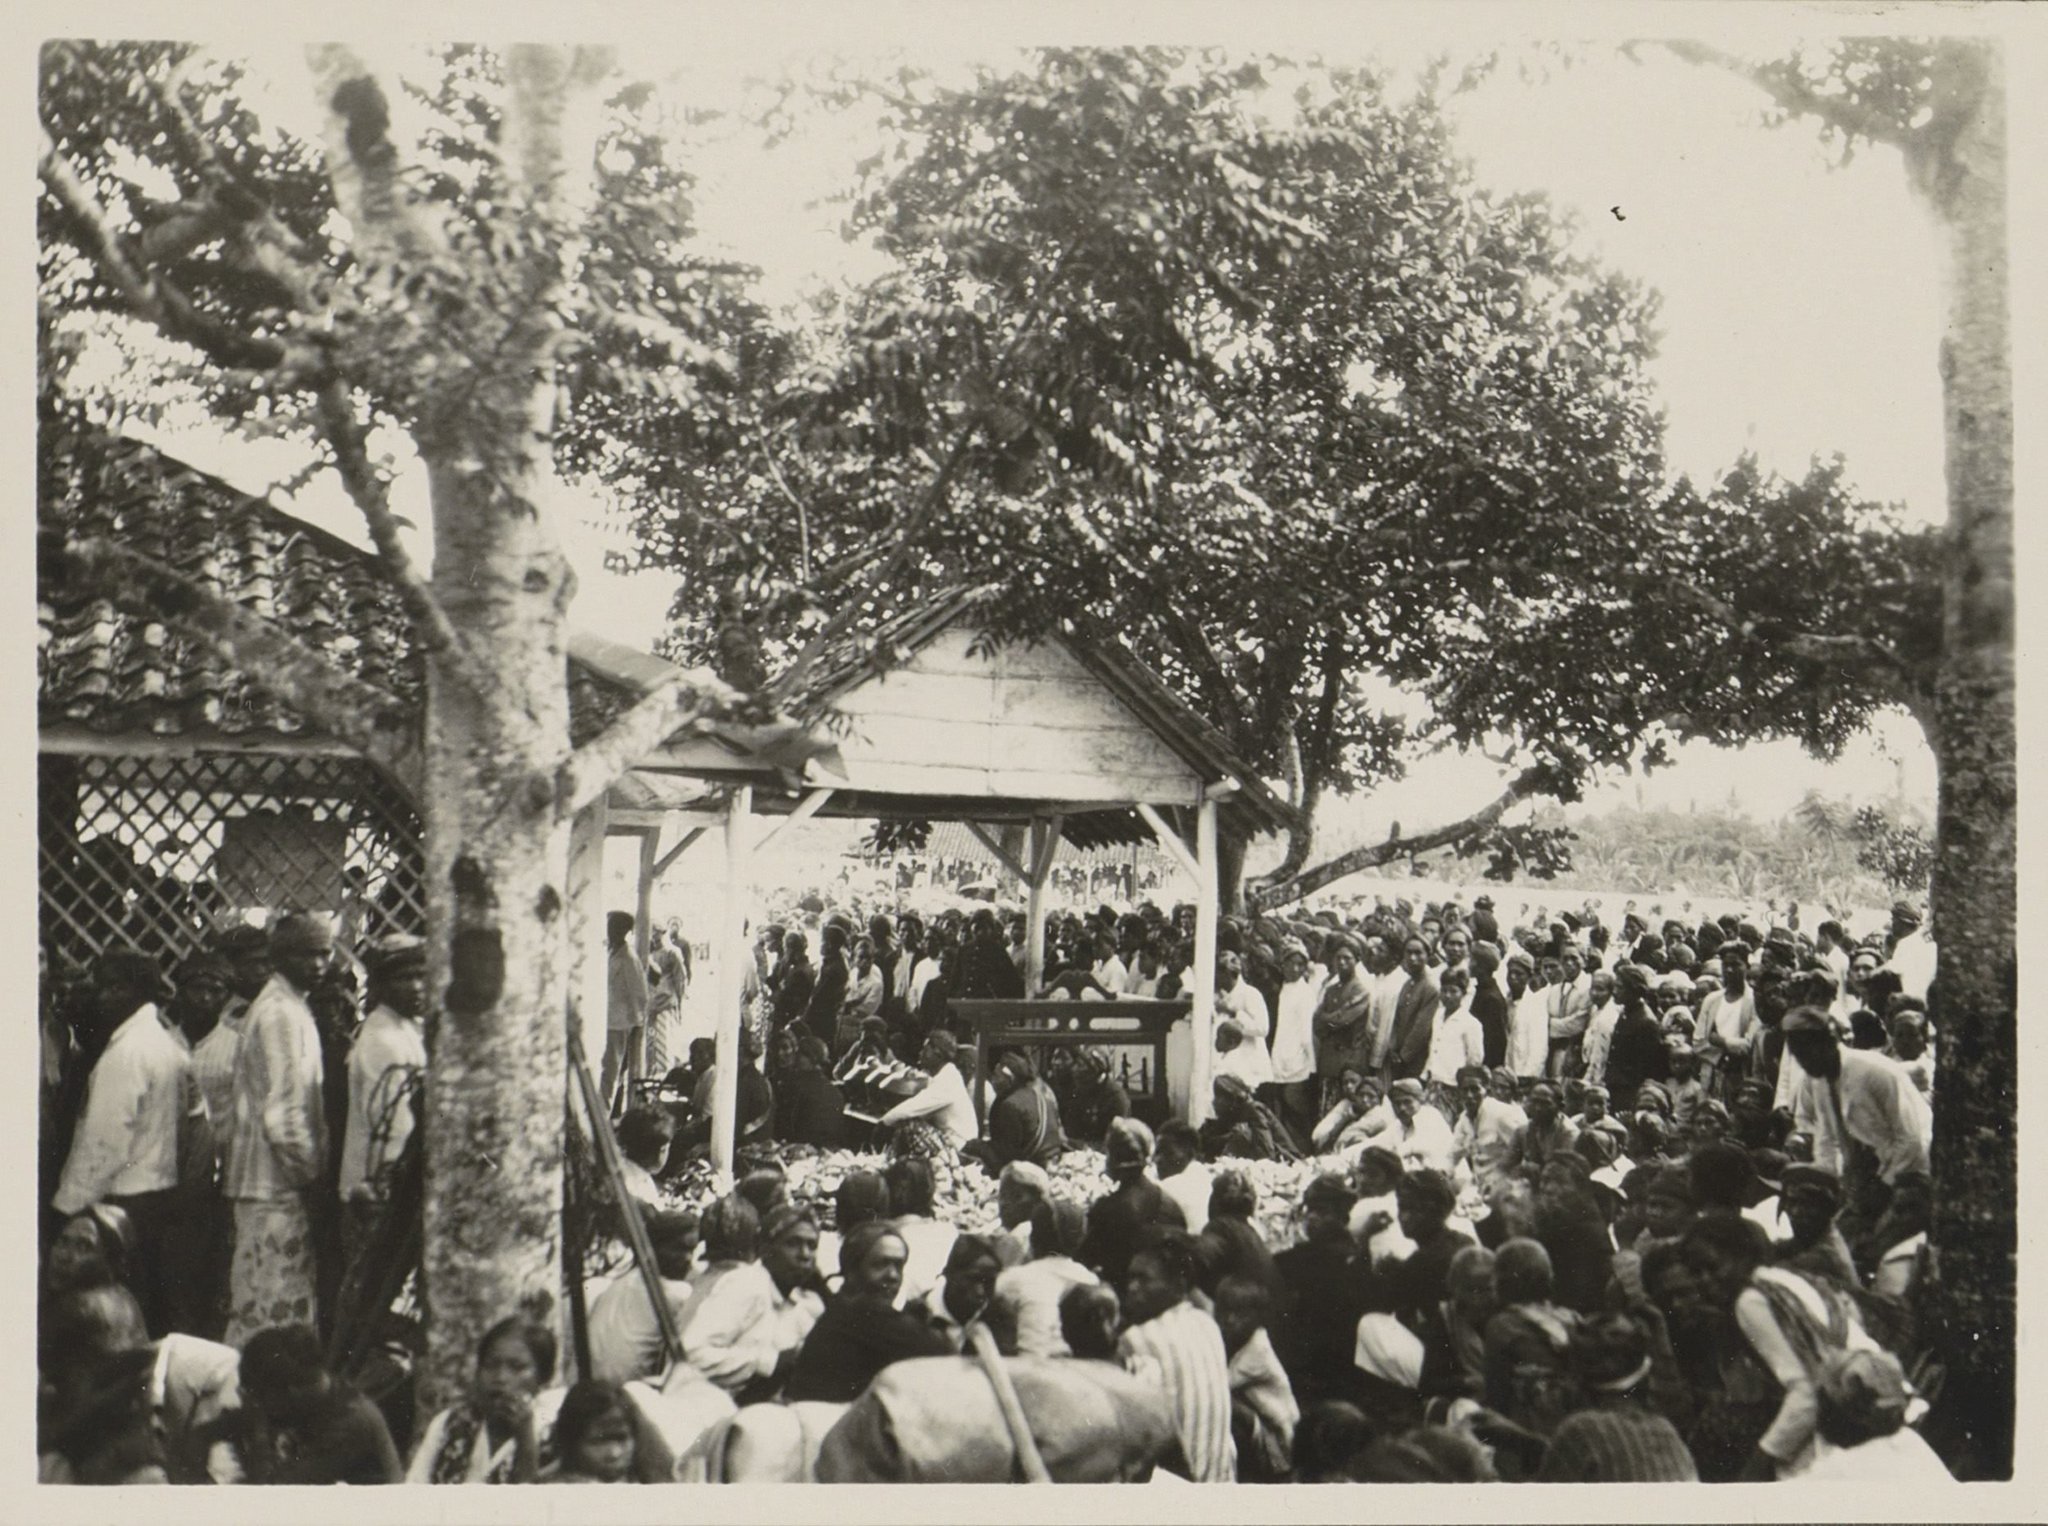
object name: photograph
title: Inwoners van Gedong Tataan verzameld bij een pendoppo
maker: Anonymous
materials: photographic support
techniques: gelatin silver print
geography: gedongtataan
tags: being welcomed ~ travelling, meeting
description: Onderdeel van Fotoalbum aangeboden aan de resident der Lampongse districten F.J. Junius door studerende ambtenaren van de bestuursschool te Batavia.